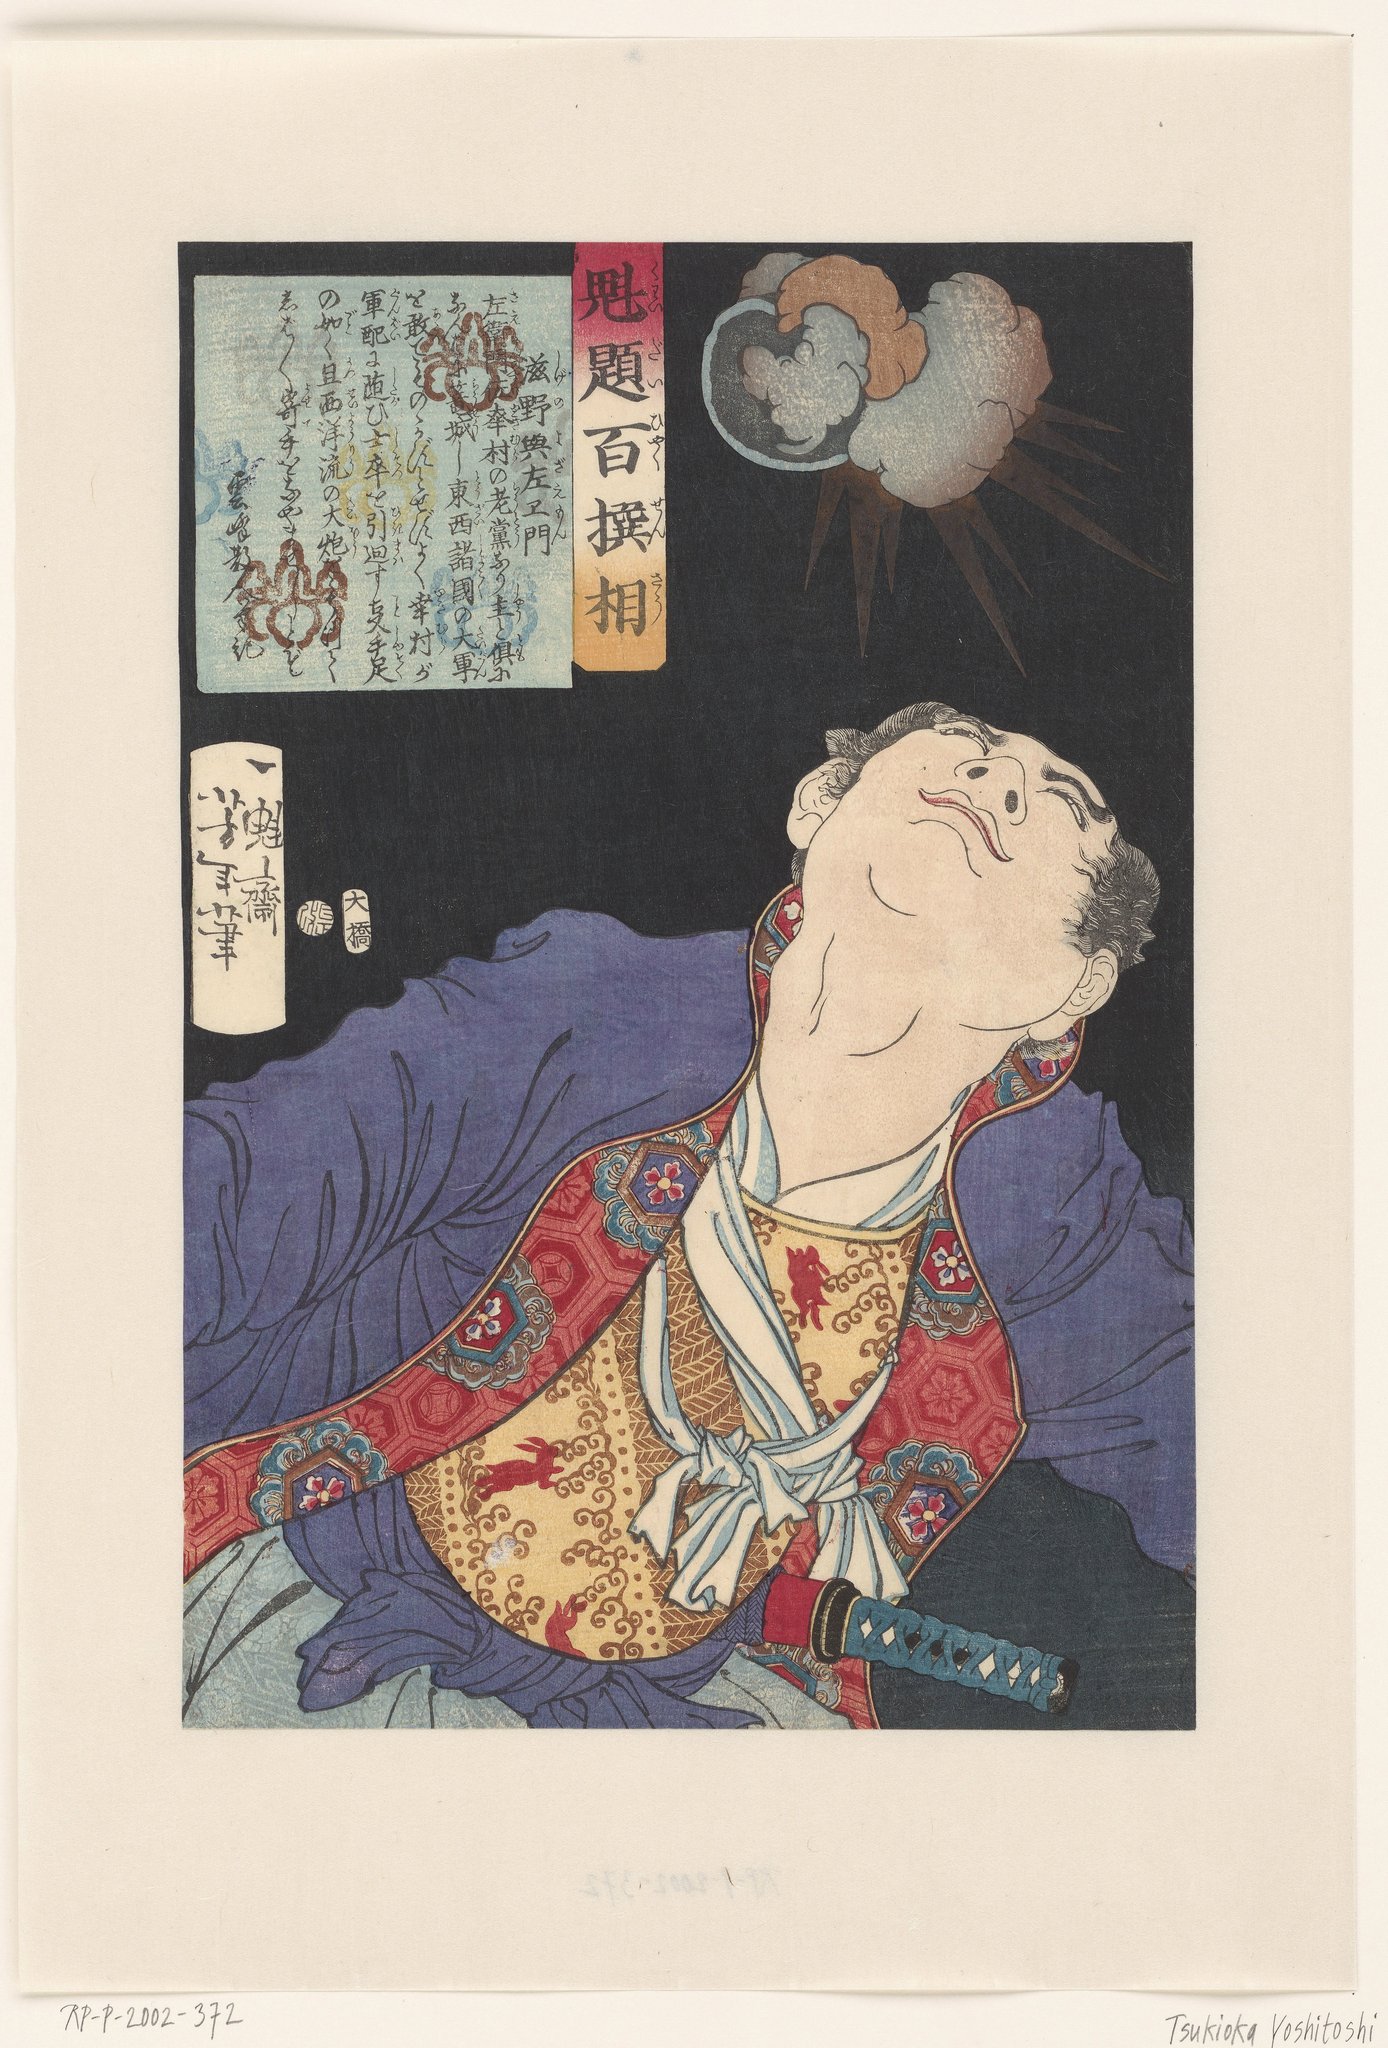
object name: print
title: Shigeno Yozaemon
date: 1801-1869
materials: paper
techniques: woodcut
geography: tokyo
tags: adult man, projectiles, explosives, etc., looking upwards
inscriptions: collector's mark: Lugt 2228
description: Shigeno Yozaemon, in paarse jas met kleurrijke voering, kijkt op naar een exploderende granaat boven hem.